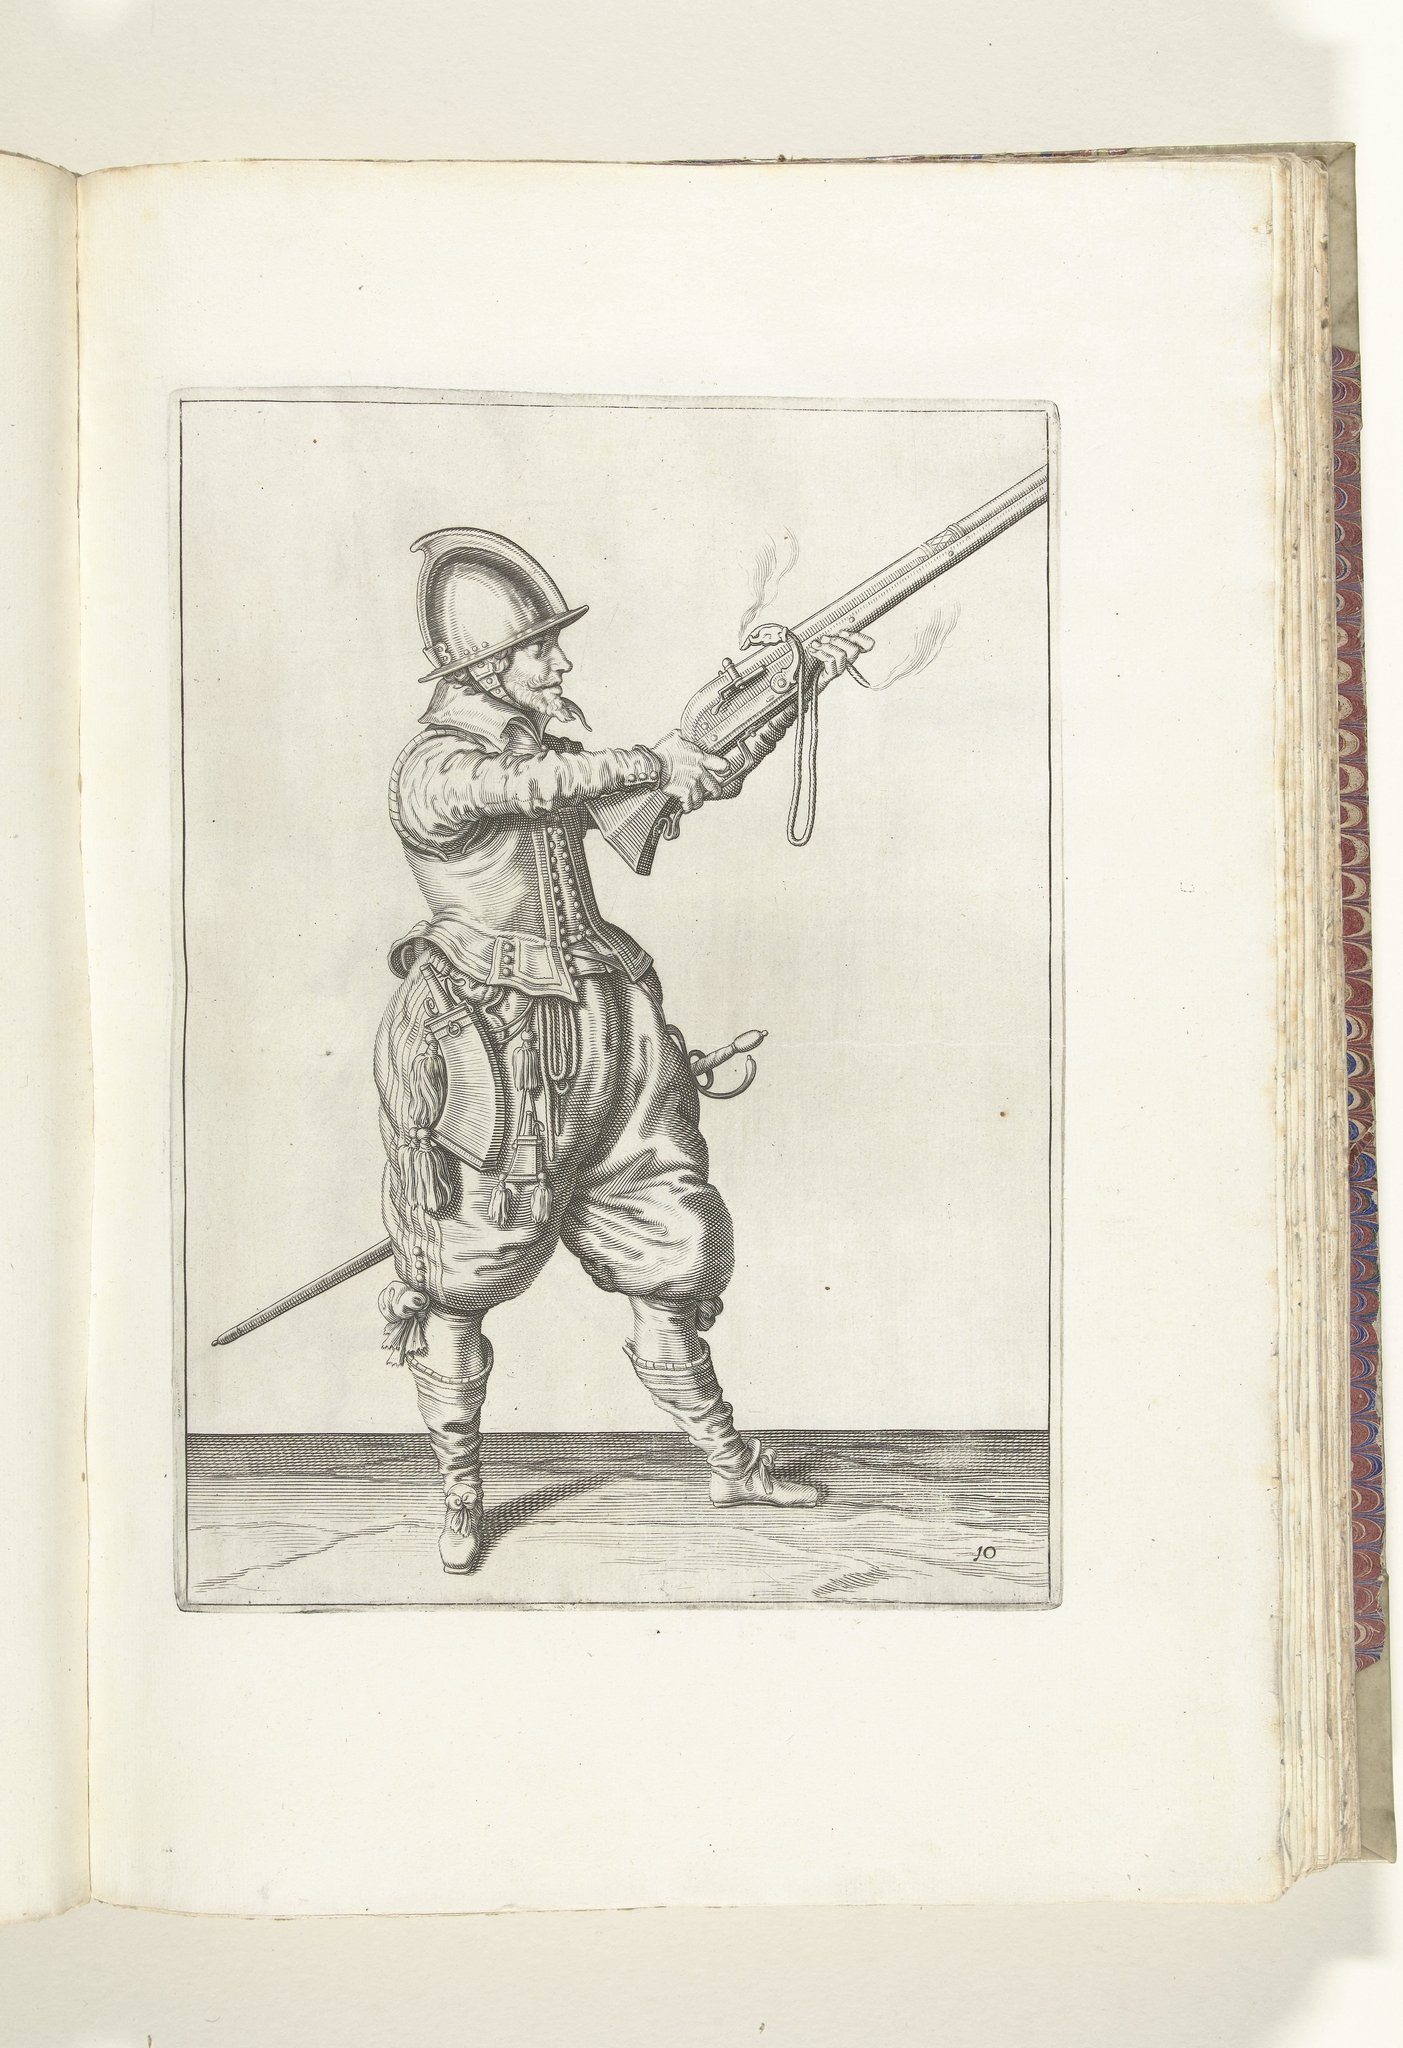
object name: print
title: Soldaat richt de roer met beide handen omhoog (nr. 10), ca. 1600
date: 1597-1607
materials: paper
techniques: engraving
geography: amsterdam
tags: the hague, maurice (prince of orange), handling of weapons ~ military training, weapons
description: Een soldaat, ten voeten uit, naar rechts, die een roer (een bepaald type vuurwapen) met beide handen vasthoudt en deze schuin omhoog richt (nr. 10), ca. 1600. Plaat 10 in de instructies voor het hanteren van de roer. Onderdeel van de illustraties in: J. de Gheyn, Wapenhandelinghe van Roers Musquetten ende spiessen, Amsterdam, 1608. Krijgswezen rond 1600.